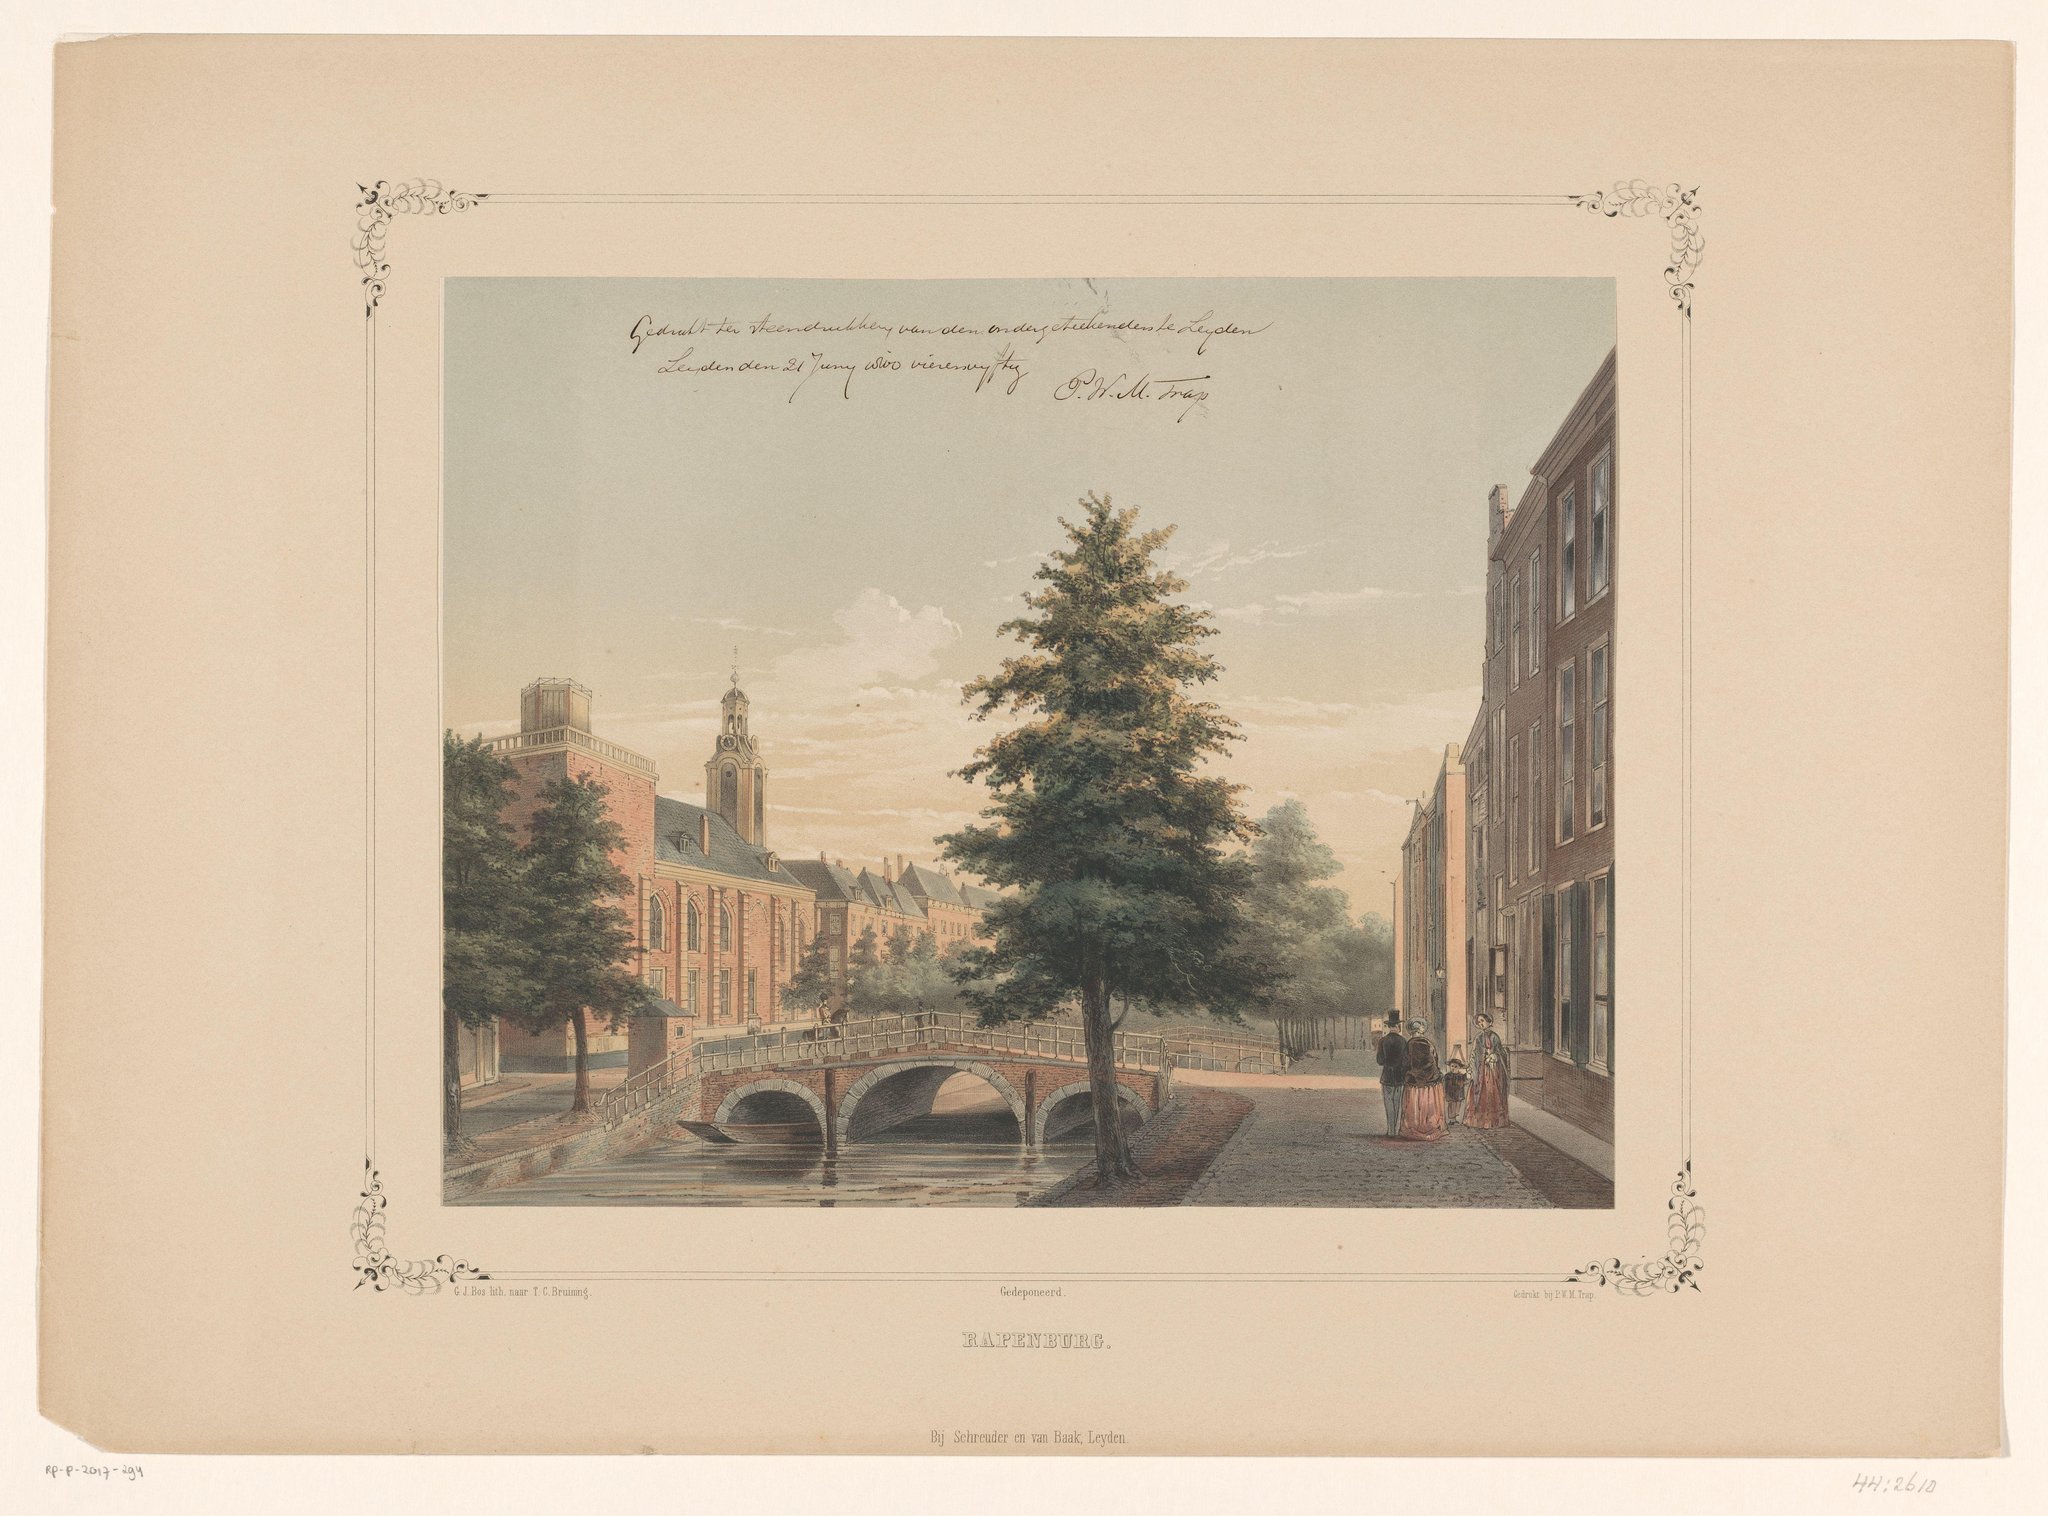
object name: print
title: Rapenburg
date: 1854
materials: paper, watercolor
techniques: lithograph, hand coloring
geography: leiden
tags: university, canals, waters (in city) (+ city(-scape) with figures, staffage), leiden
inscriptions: : ‘Gedrukt ter steendrukkerij van den ondergetekenden te Leyden / Leyden den 21 Juny 1800 vierenvijftig / P.W.M. Trap’, : ‘Gedeponeerd.’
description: Links het academiegebouw van de universiteit.